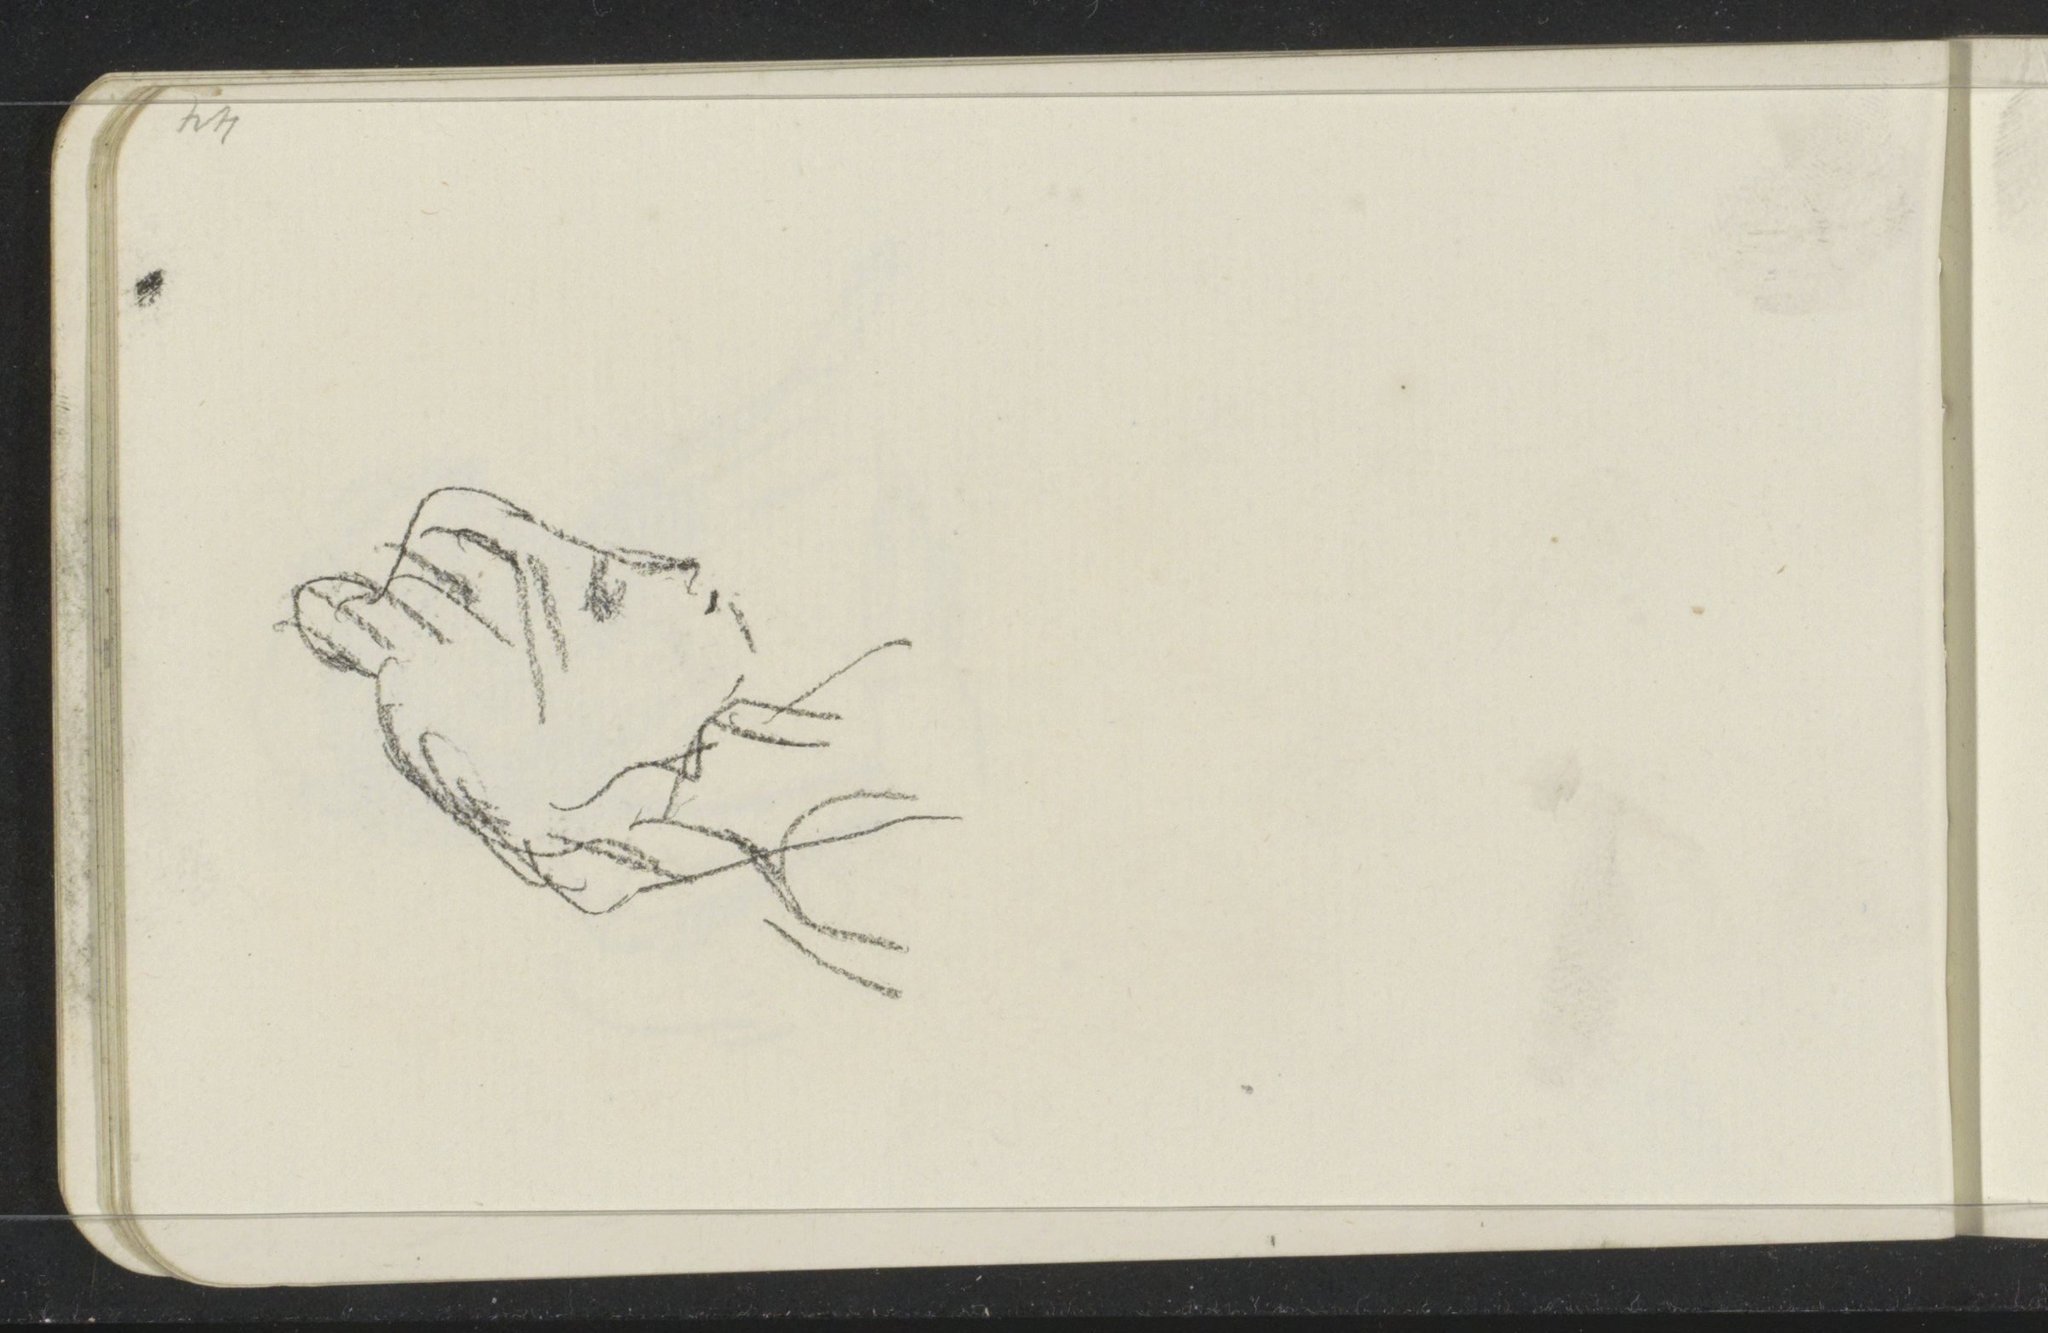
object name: sketchbook leaf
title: Vrouwenhoofd, in profiel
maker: isaac israels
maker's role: draughtsman, painter, print maker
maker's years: 1865-1934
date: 1875-1934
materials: chalk, paper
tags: head (human) - aa - female human figure (+ sideview, profile)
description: Blad 13 verso uit schetsboek LXII met 28 bladen.